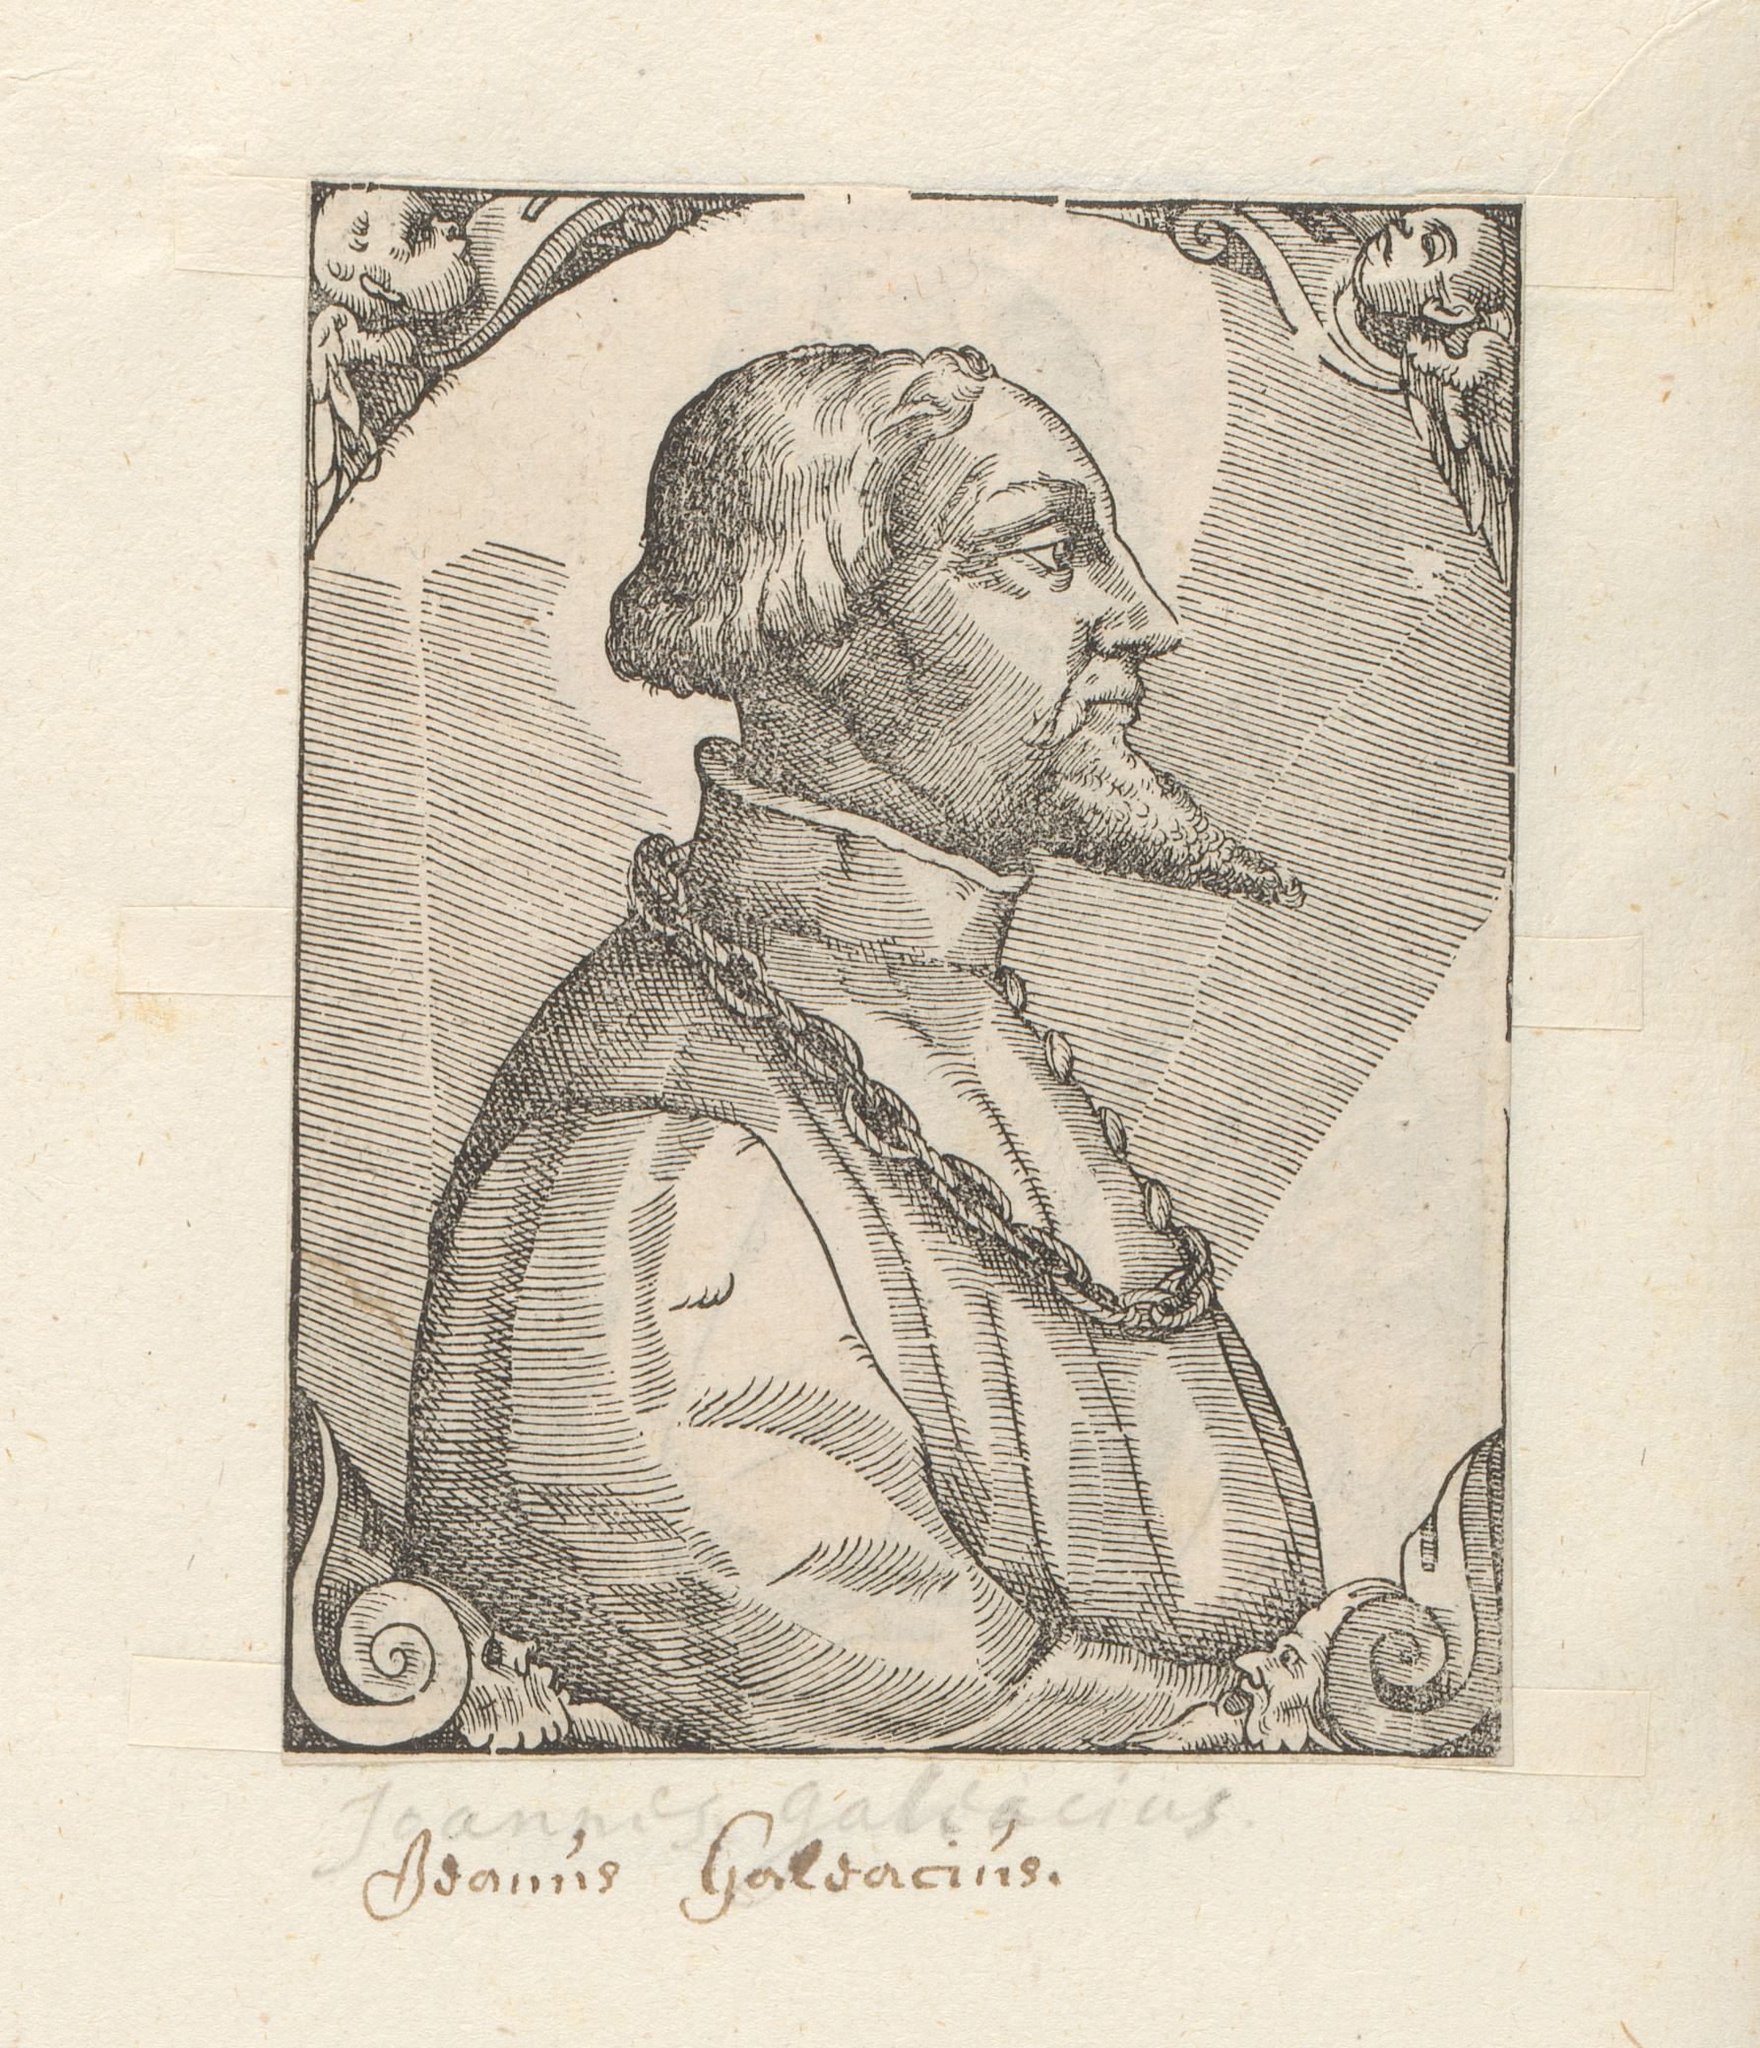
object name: print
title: Portret van Gian Galeazzo Visconti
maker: Anonymous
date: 1549-1575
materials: paper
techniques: woodcut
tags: historical persons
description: Prent gebruikt in: Giovio, Paolo. Elogia Virorum bellica virtute illustrium (...). Bazel: Peter Perna, 1575.